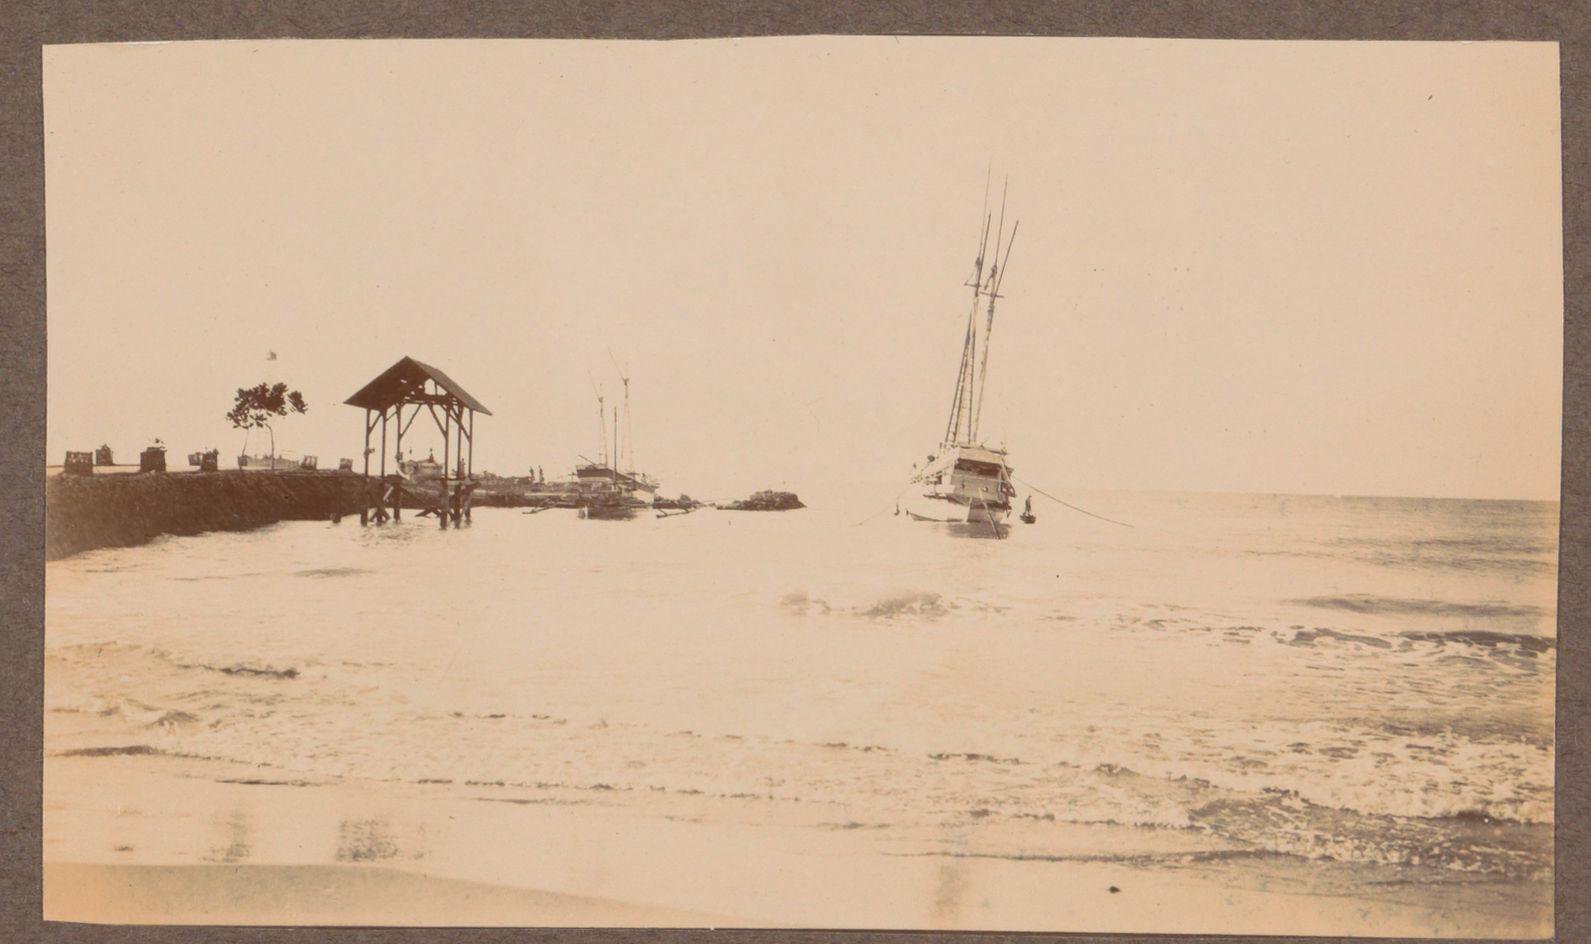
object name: photograph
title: Zeilschip voor anker voor de kust van Nederlands-Indië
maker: klaas kleiterp (i)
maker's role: arts, officier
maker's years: 1892-1943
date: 1920-1930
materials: paper, photographic support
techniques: daylight paper print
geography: dutch east indies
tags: sailing-ship, sailing-boat, coast, dutch east indies, the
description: Onderdeel van Fotoalbum van de familie Kleiterp-Vermeulen met opnames van Nederlands-Indië.